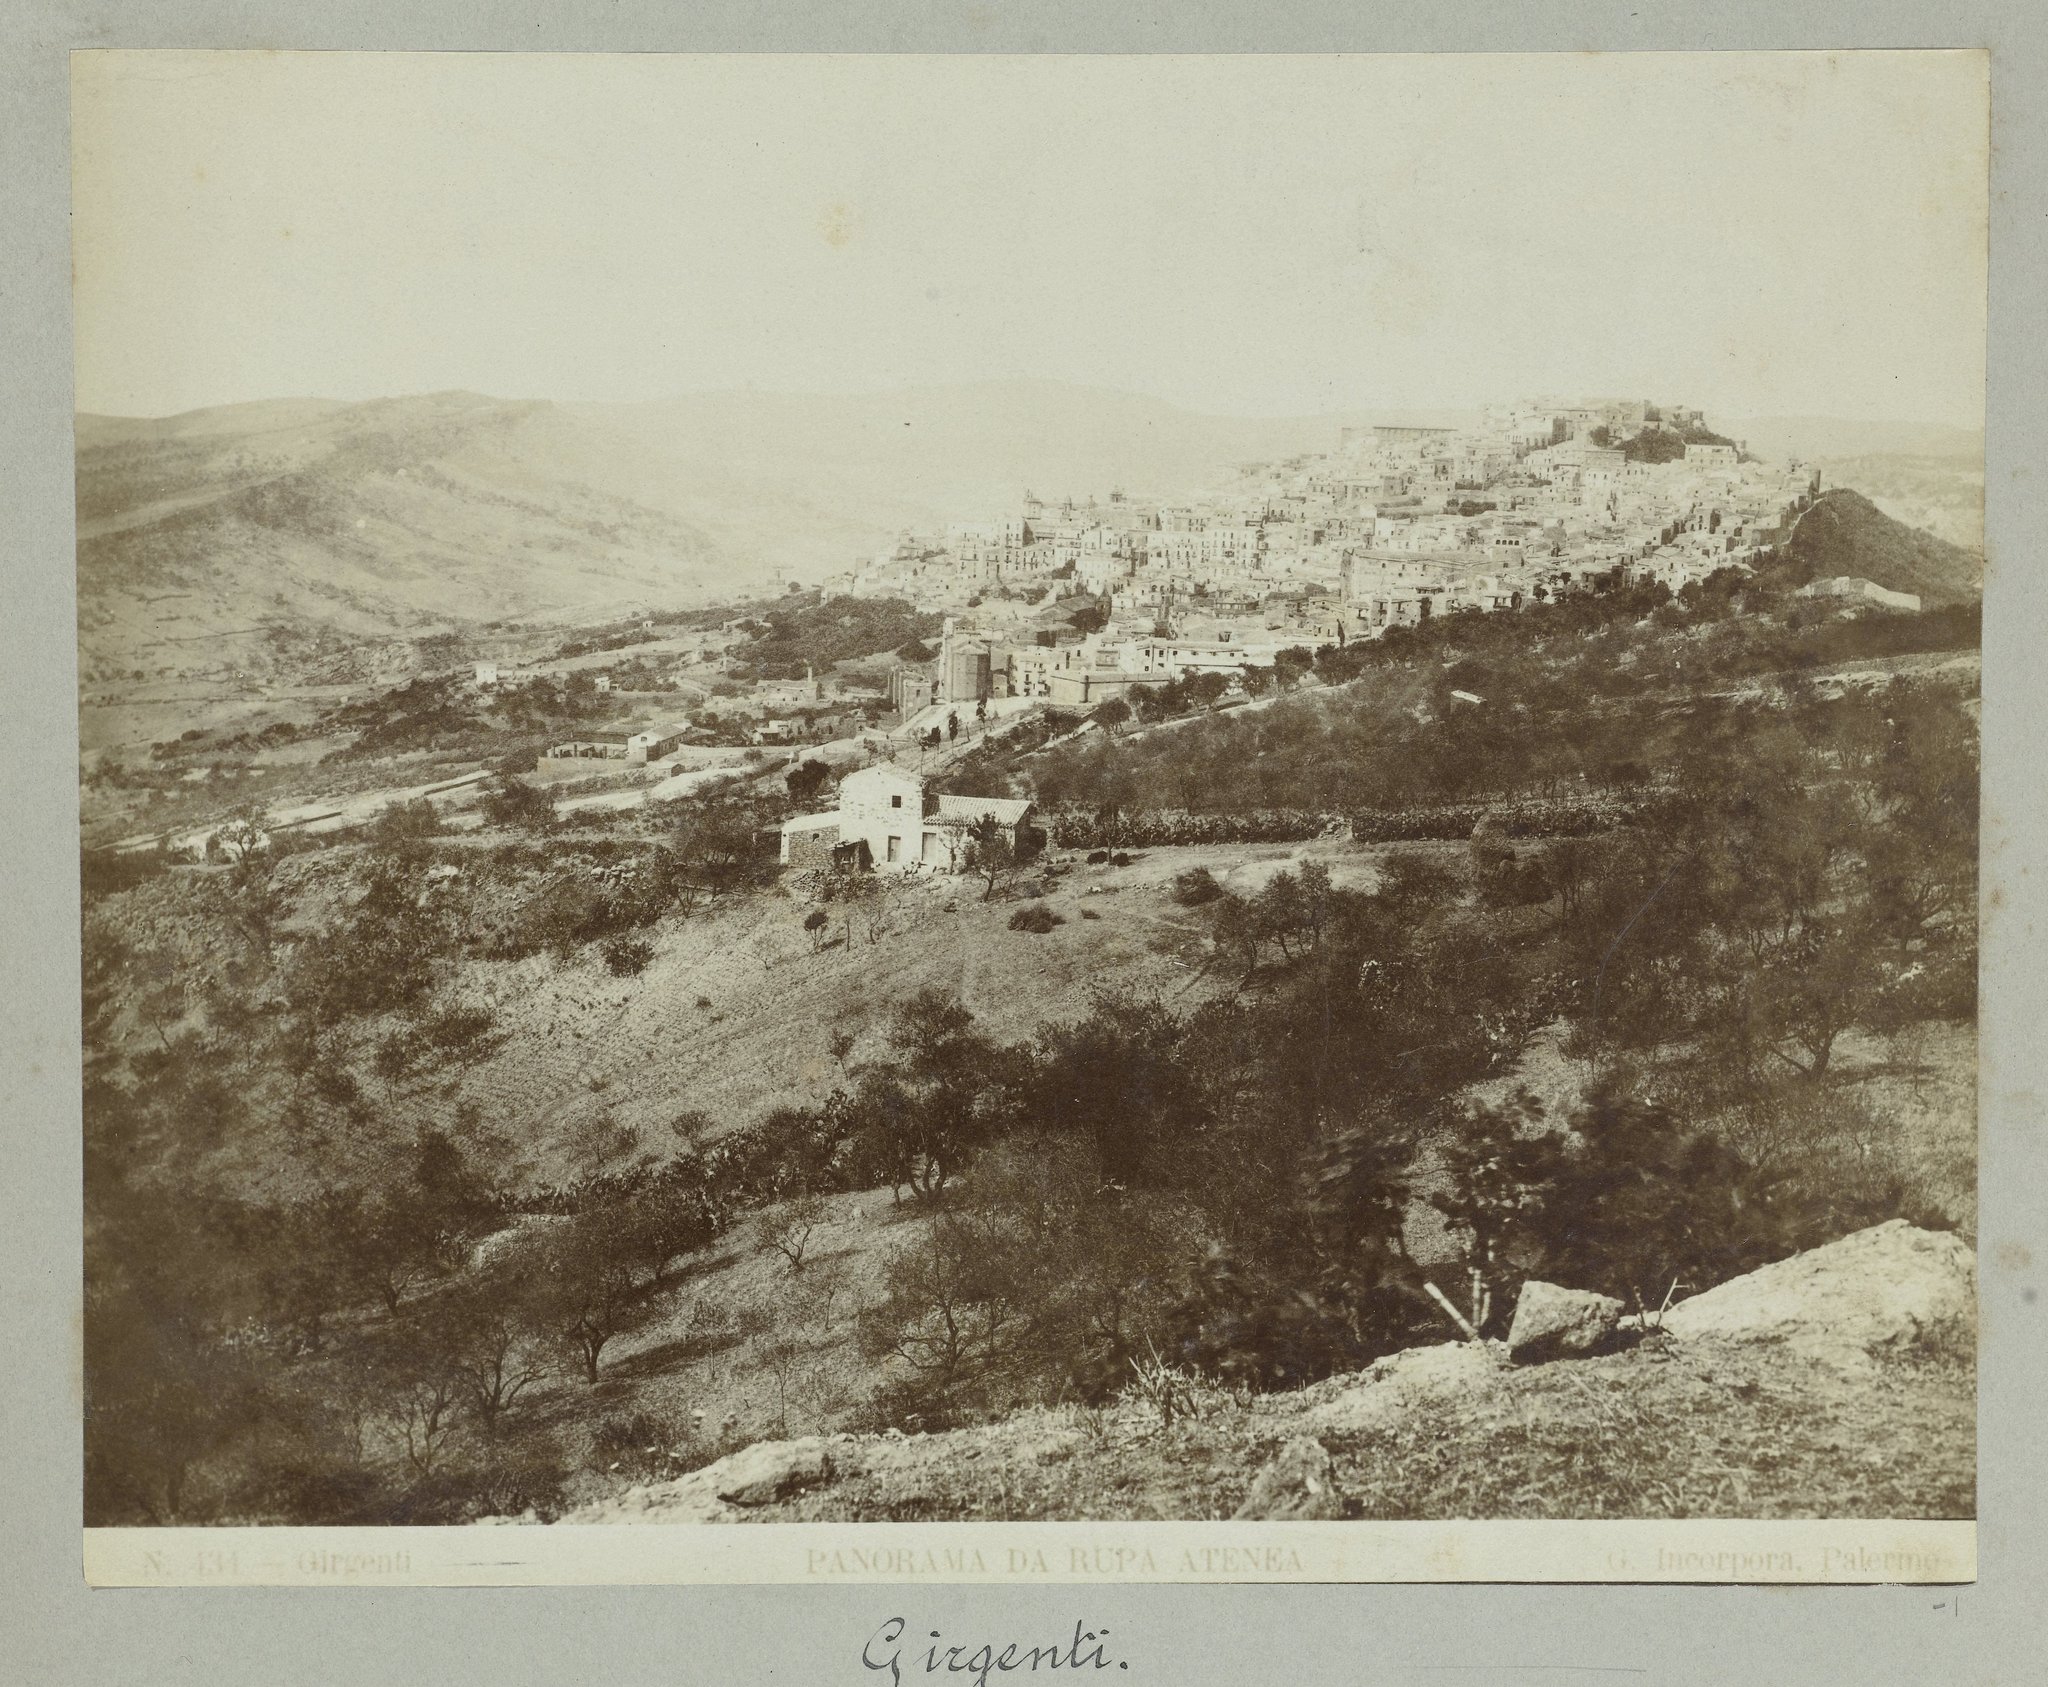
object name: photograph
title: Girgenti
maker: giuseppe incorpora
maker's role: fotograaf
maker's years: 1834-1914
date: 1893-1903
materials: cardboard, photographic support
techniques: albumen print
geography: palermo